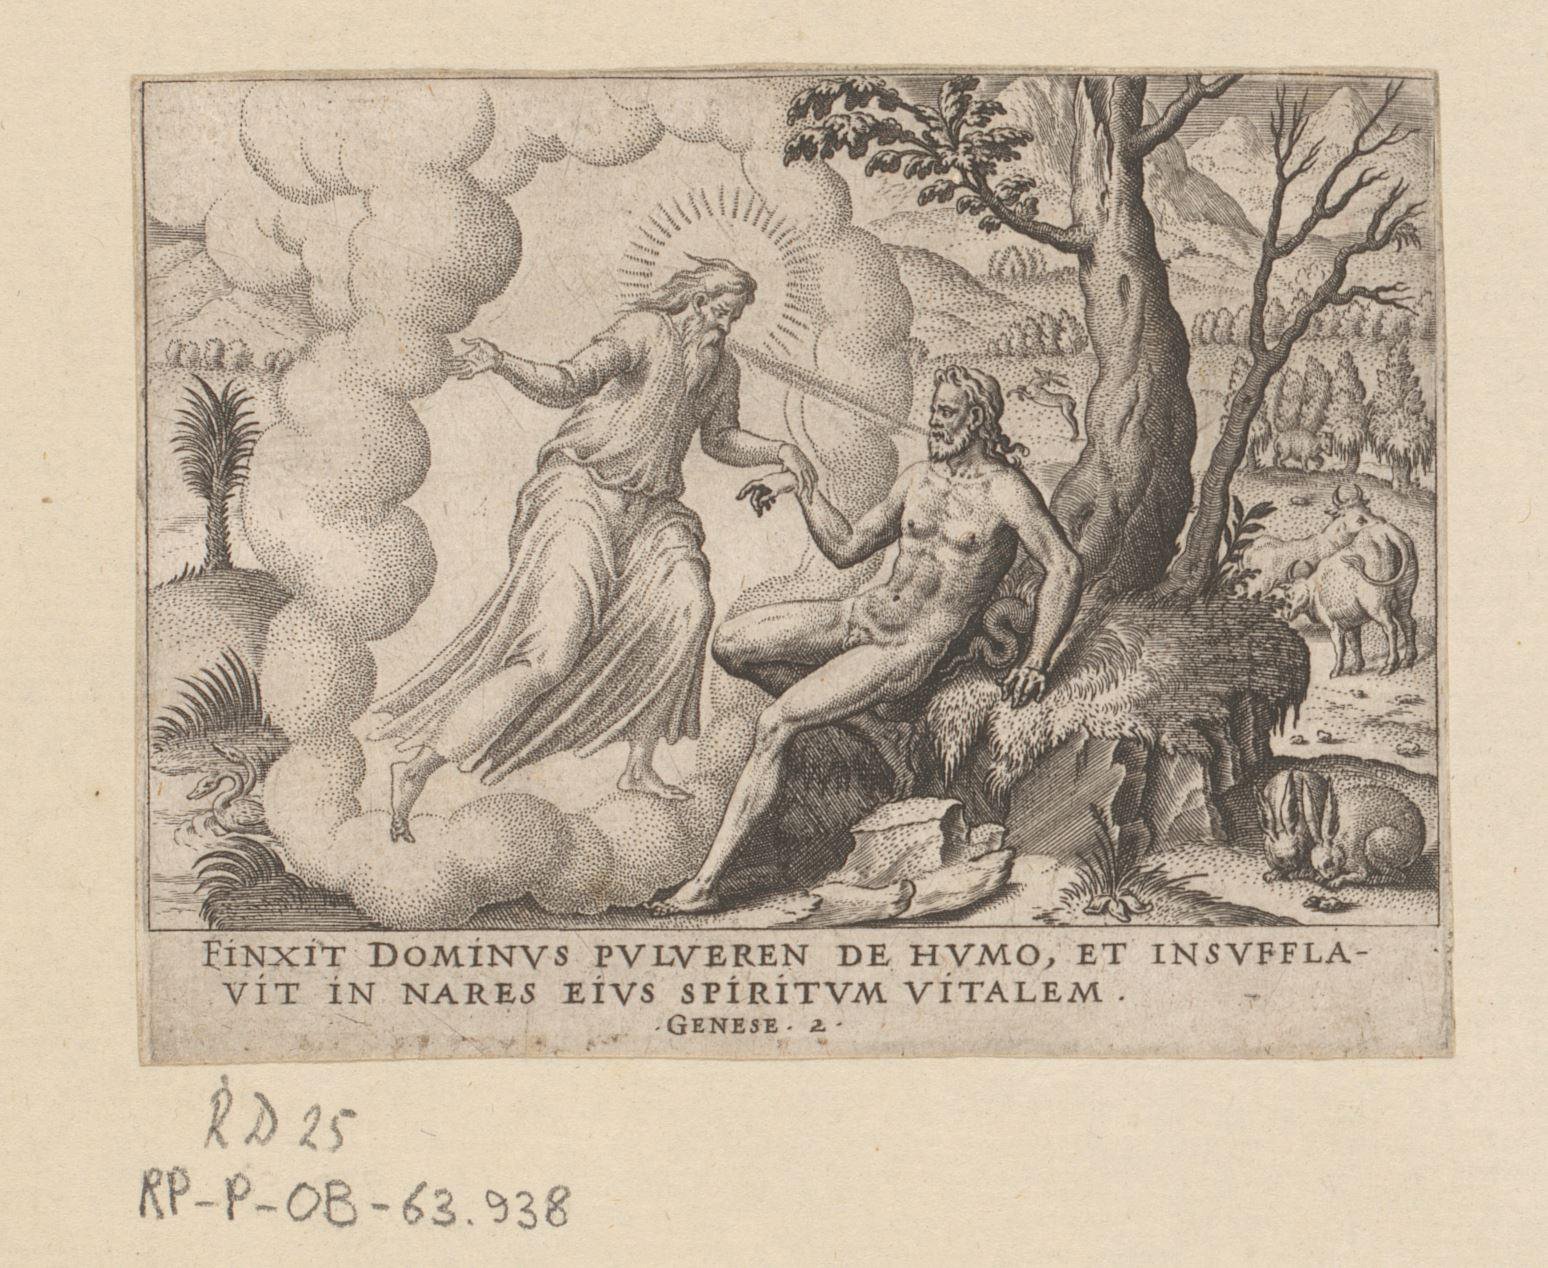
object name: print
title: Histoire de la Genèse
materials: paper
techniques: engraving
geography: france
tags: the man (adam) comes to life: usually god reaches out his hand or breathes life into his nostrils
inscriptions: collector's mark: Lugt 240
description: Maakt deel uit van een serie met mogelijk kopieën naar prenten door Etienne Delaune met illustraties bij de Genesis.